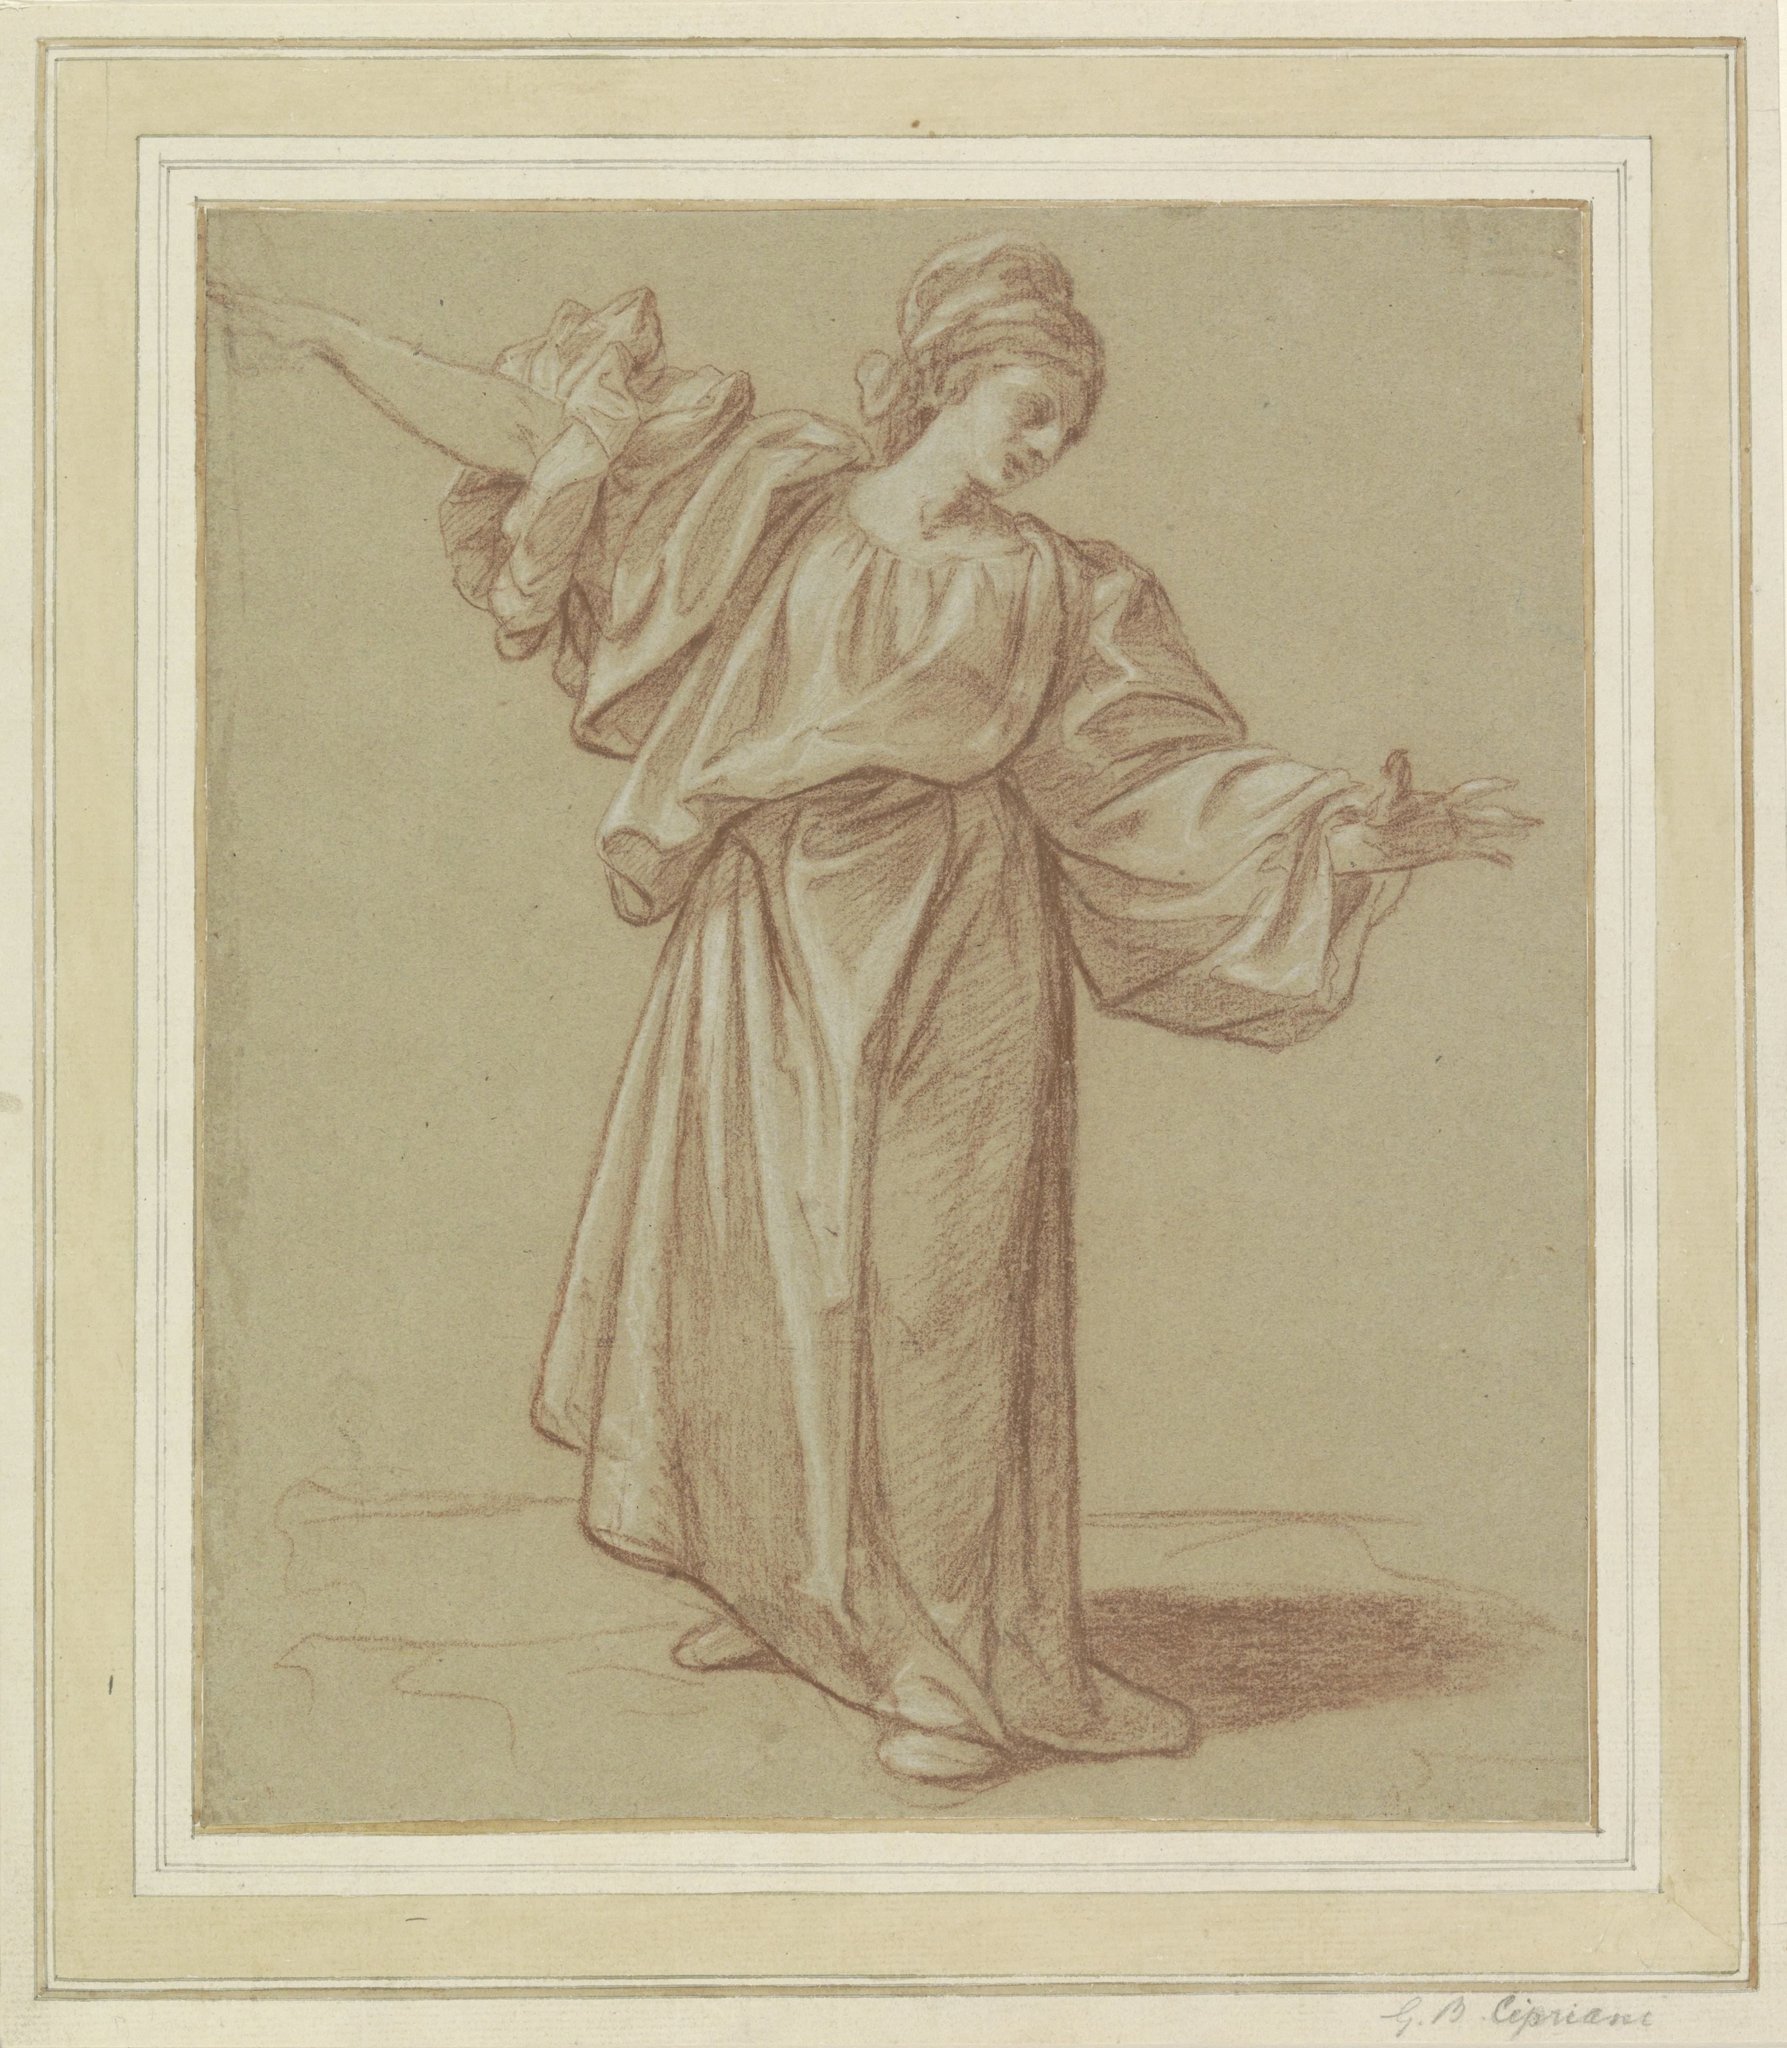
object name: drawing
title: Staande jonge vrouw met gespreide armen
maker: giovanni battista cipriani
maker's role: draughtsman, print maker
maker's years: 1727-1785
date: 1737-1785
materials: chalk, paper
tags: standing figure - aa - female human figure